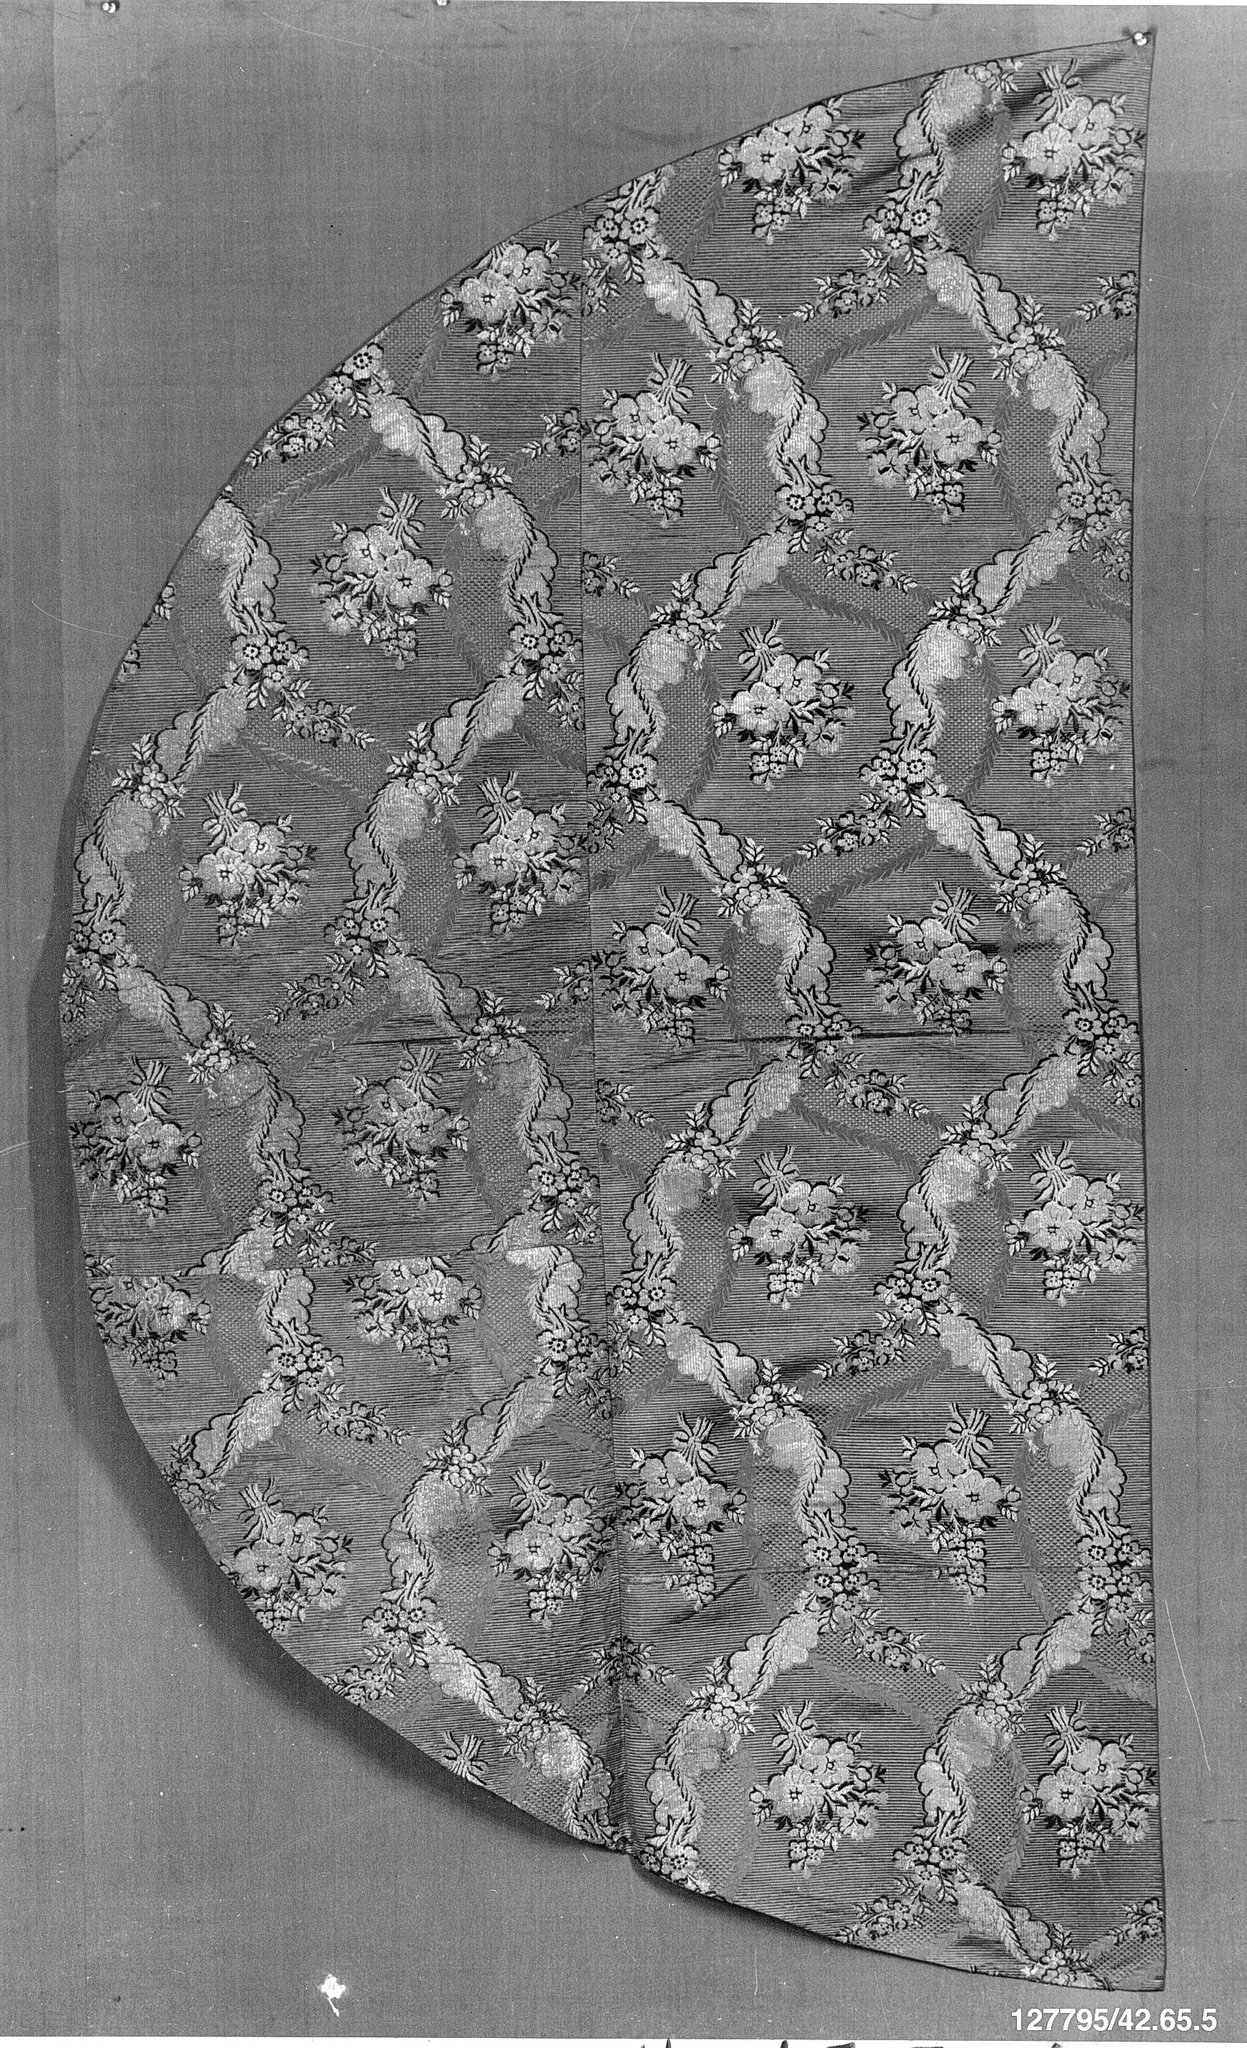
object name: piece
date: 1760-1770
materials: metal thread, silk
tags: flowers